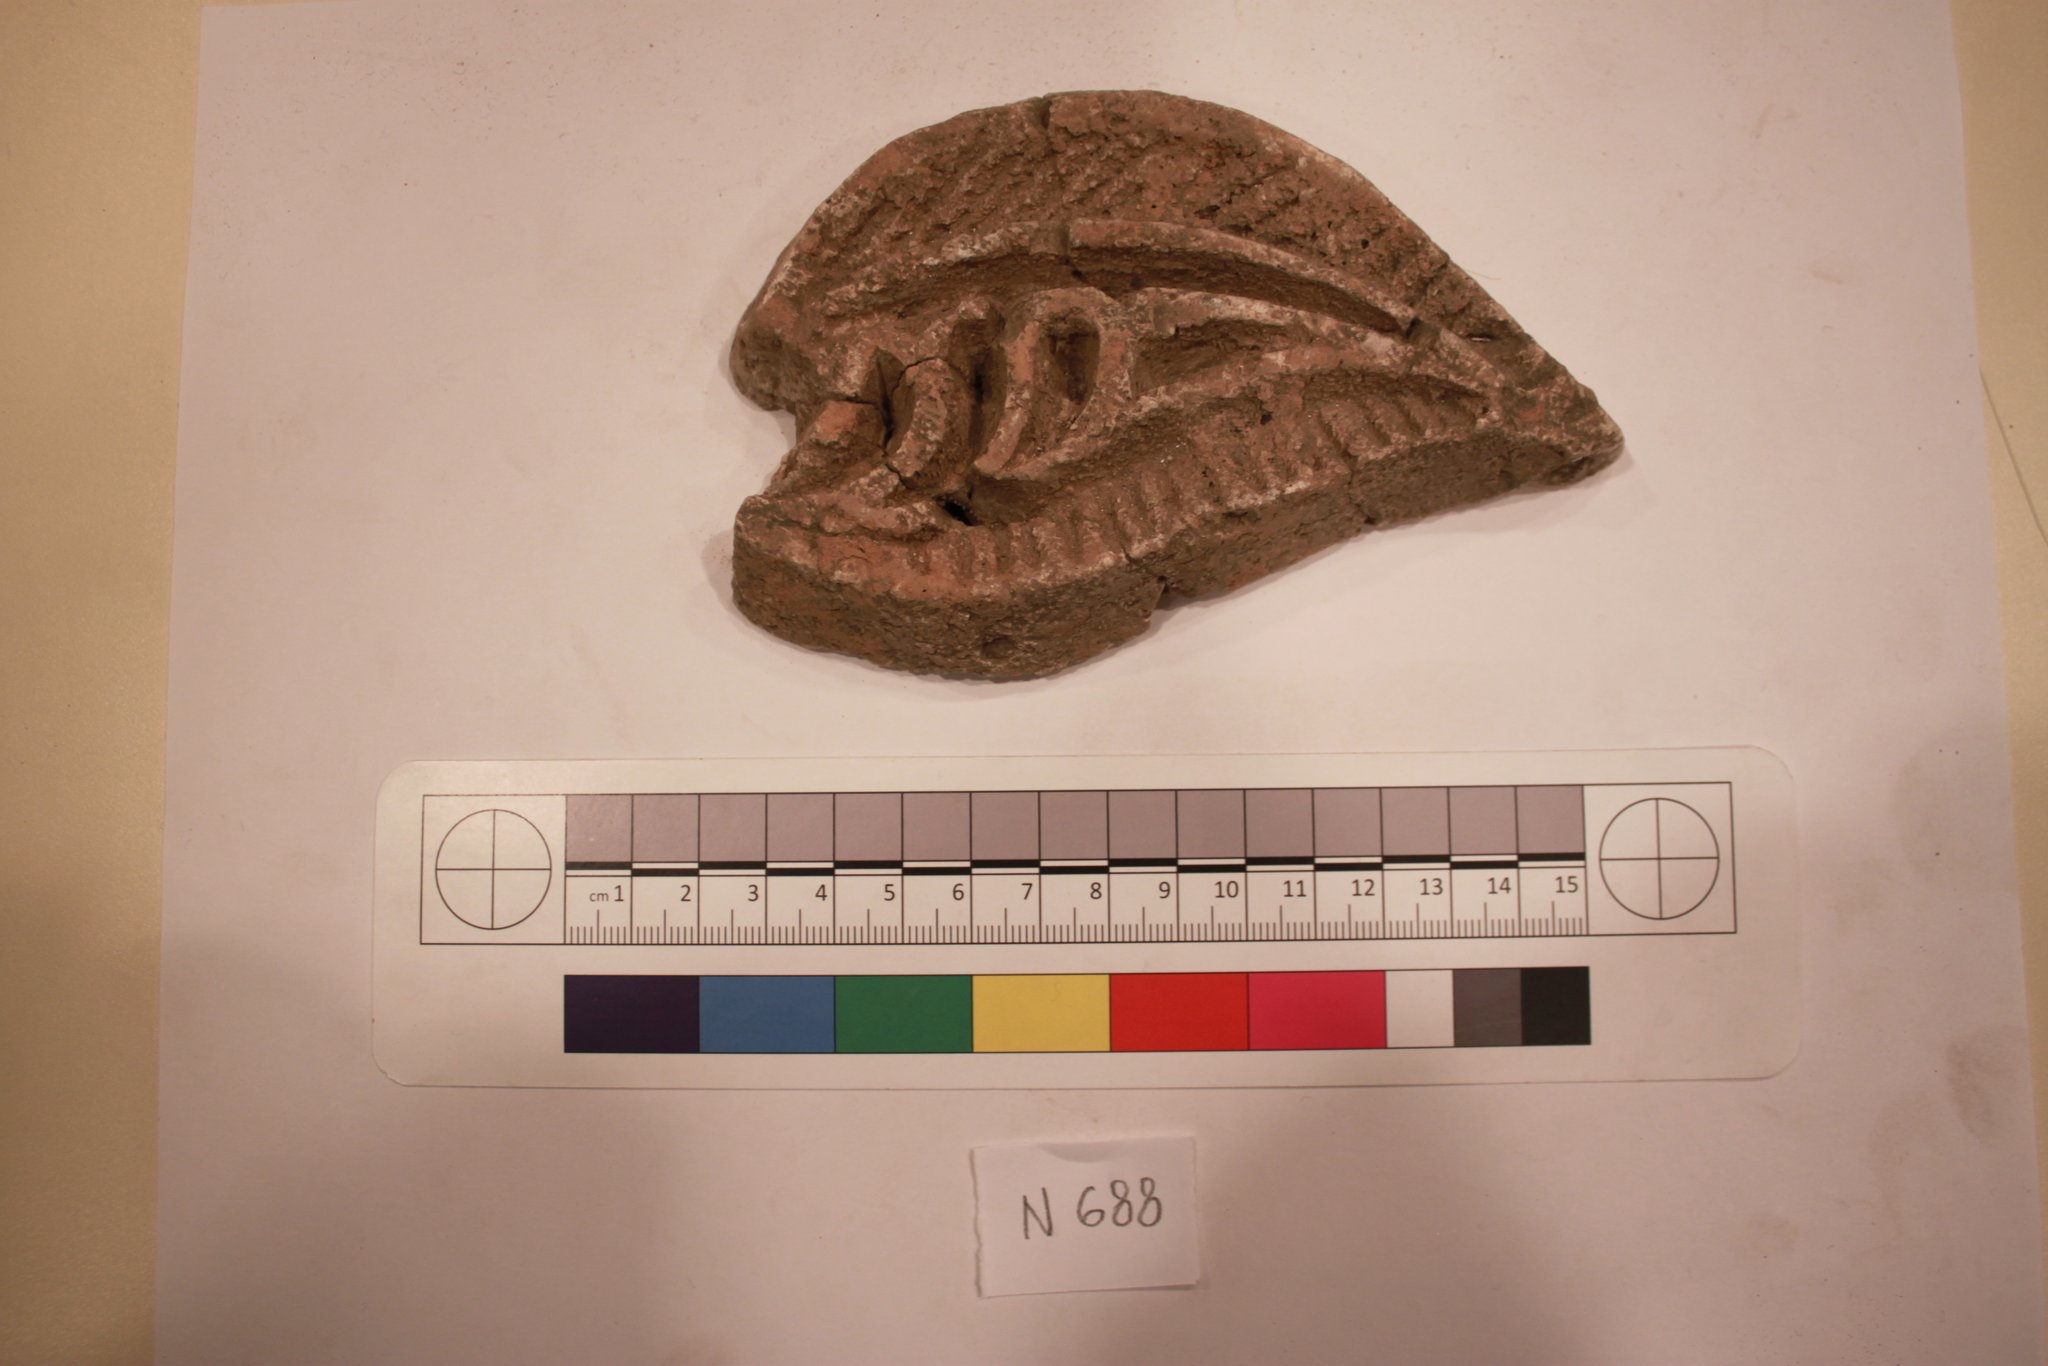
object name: fragment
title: Stucco Fragment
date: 701-1200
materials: plaster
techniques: carving, painting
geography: iran